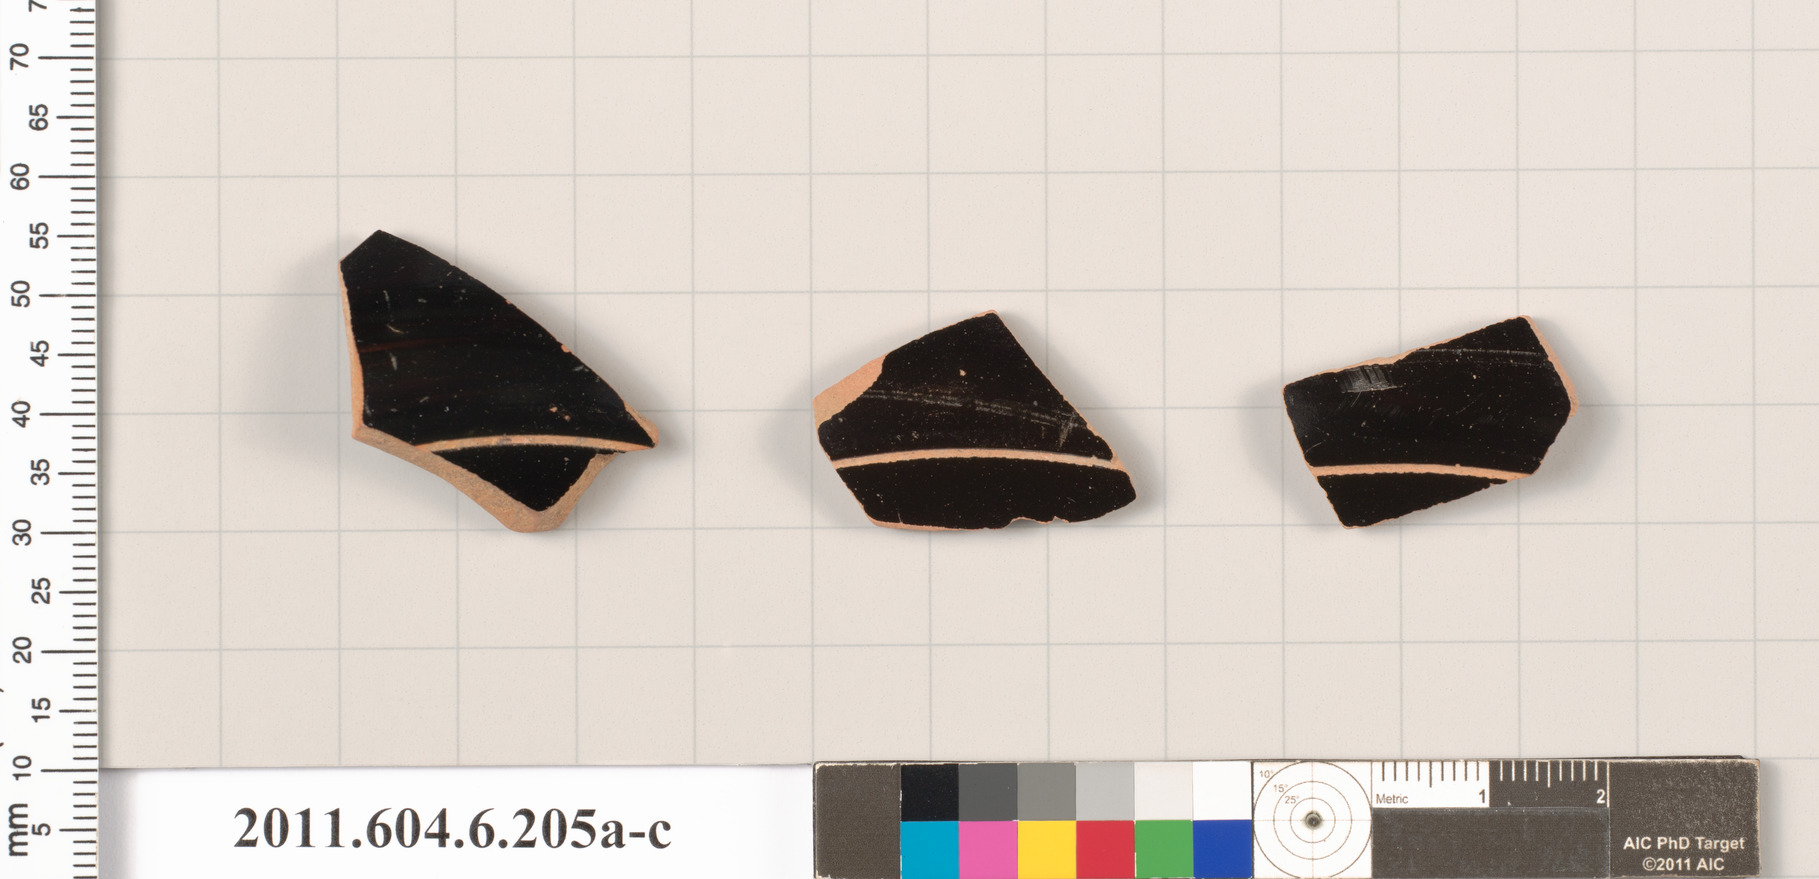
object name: undetermined open shape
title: Terracotta fragments of open shapes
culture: greek, attic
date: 500-401 BCE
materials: terracotta